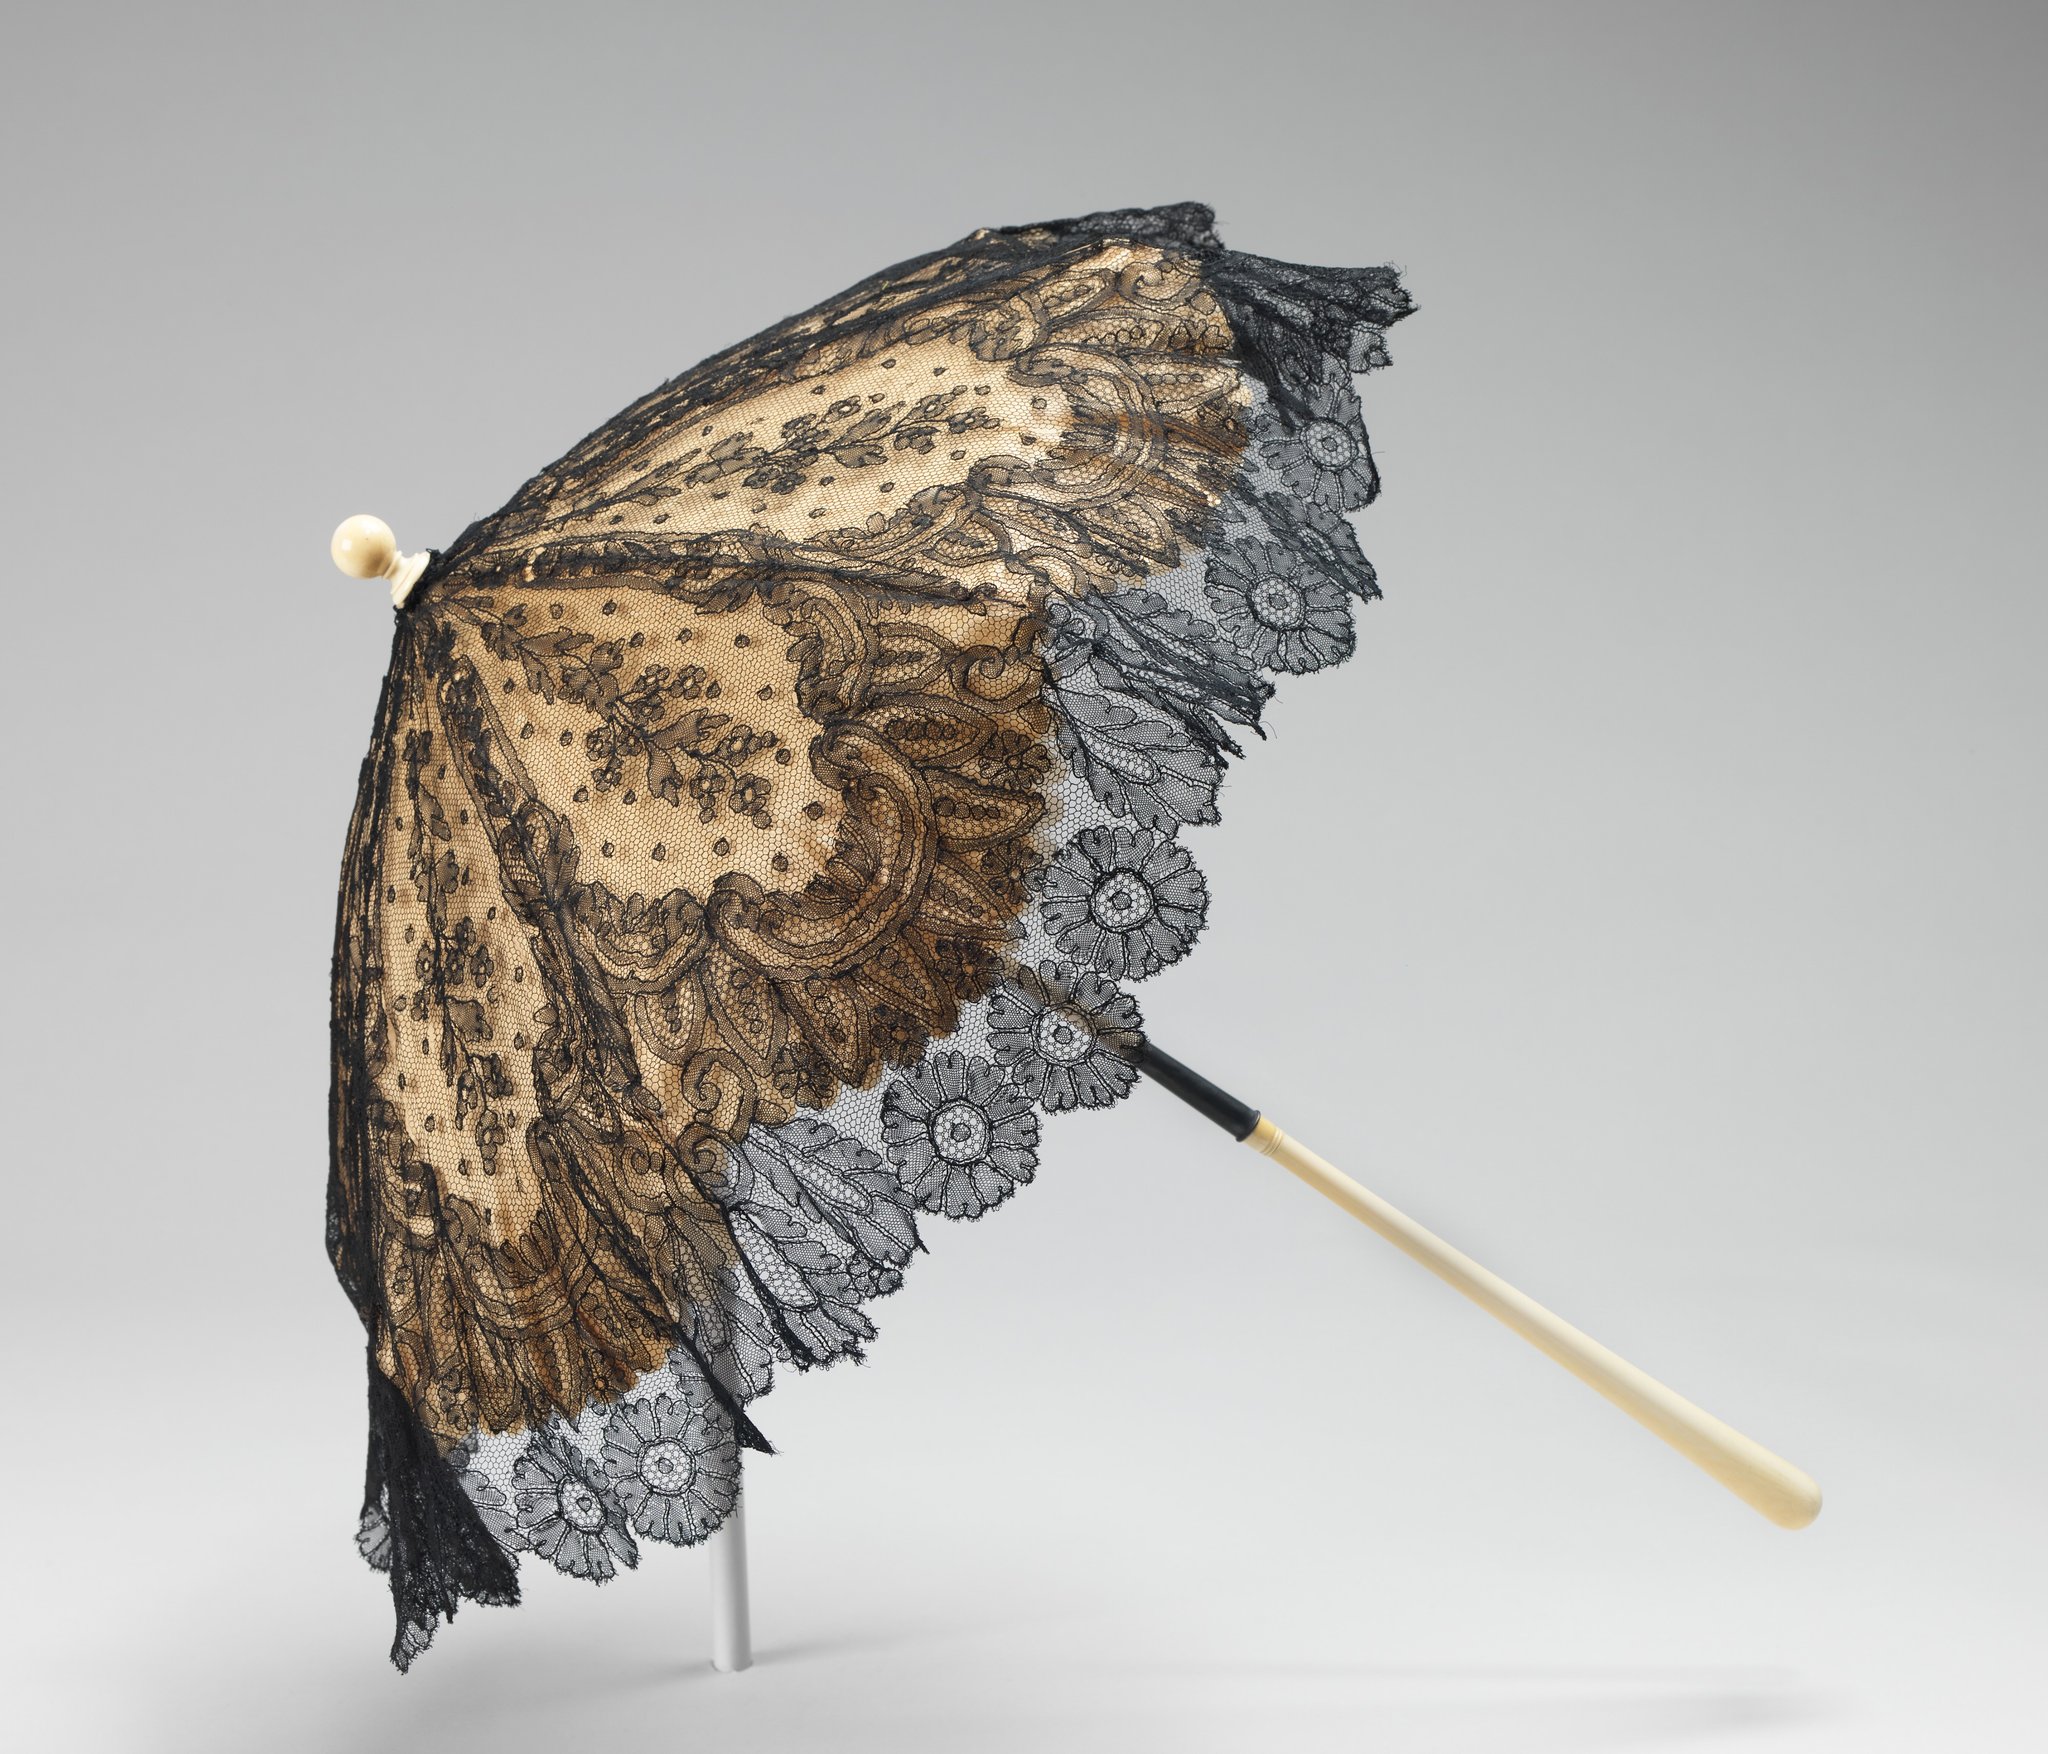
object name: parasol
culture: french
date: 1860-1869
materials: ivory, metal, silk, wood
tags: flowers